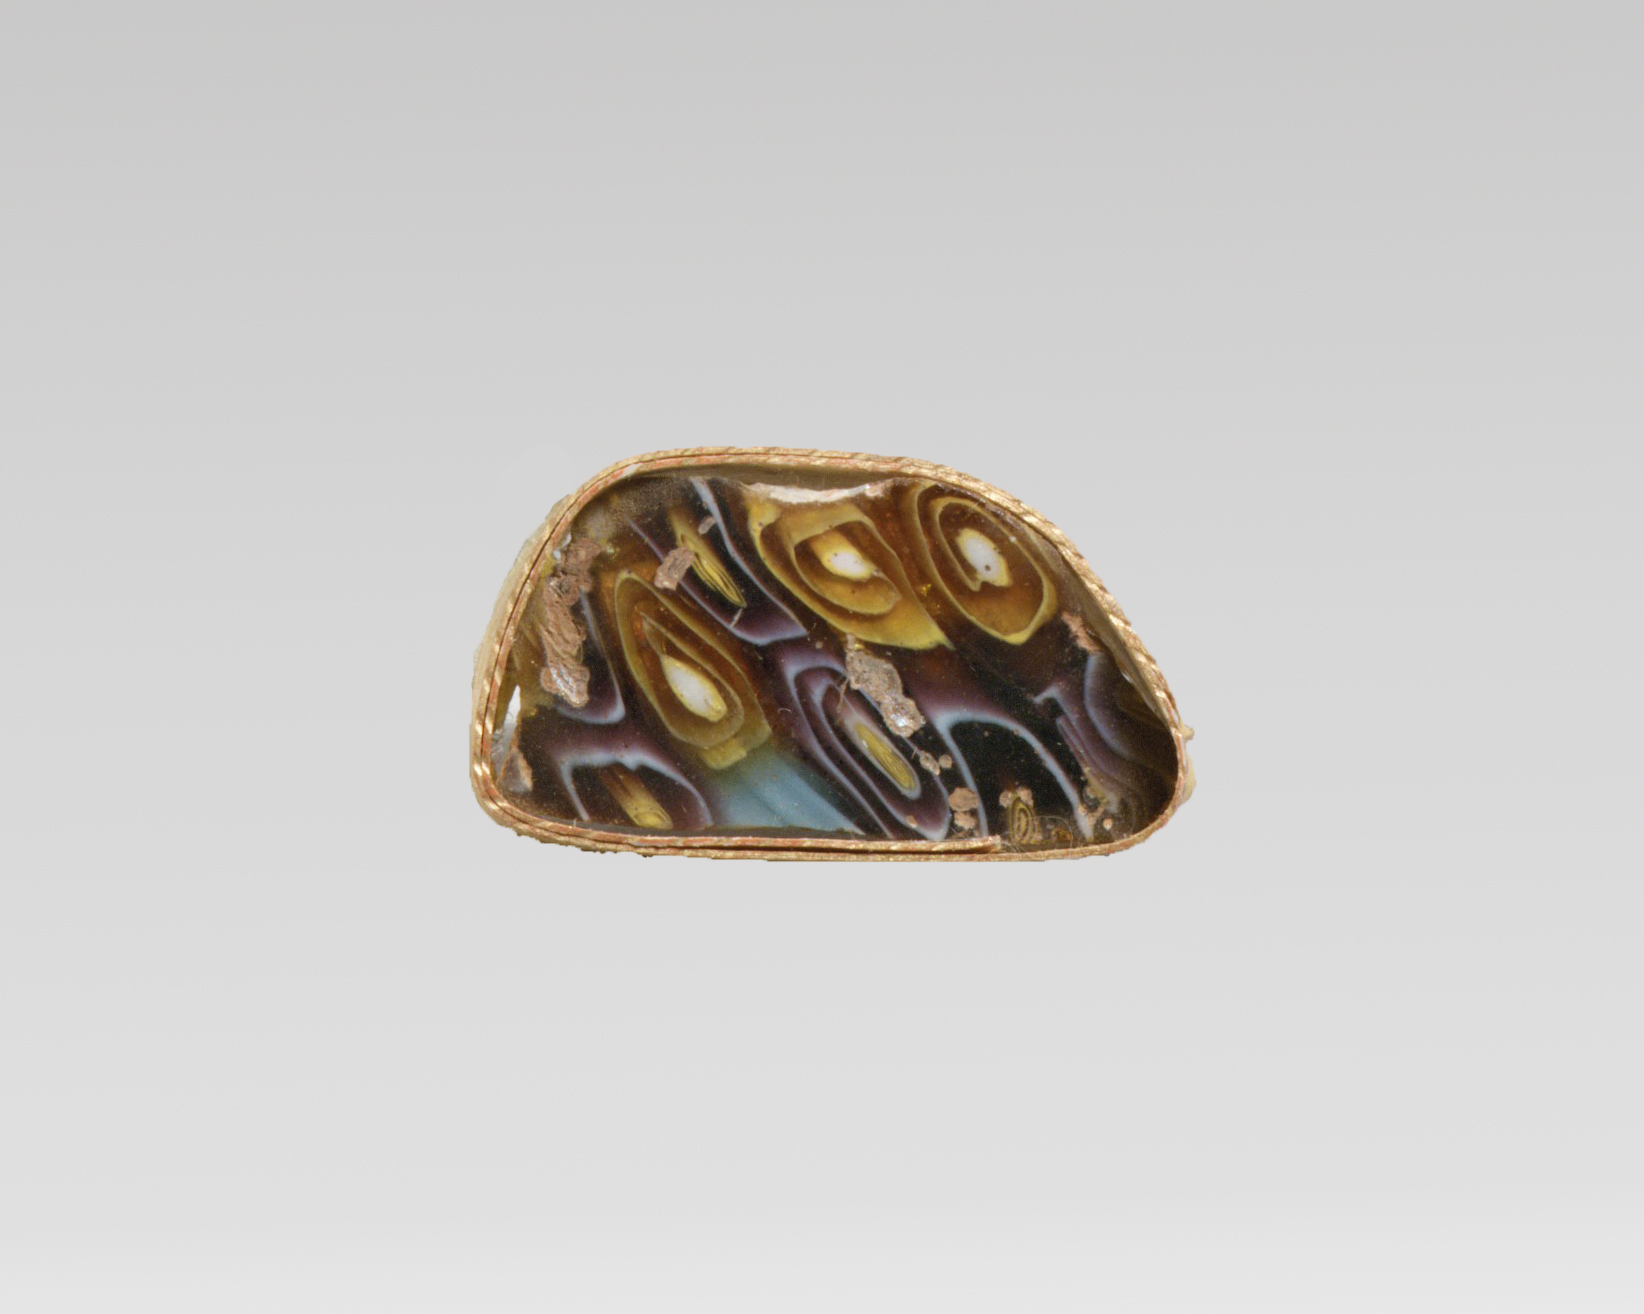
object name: fragment, mosaic bowl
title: Glass mosaic carinated bowl fragment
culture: roman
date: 34 BCE-33 CE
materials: glass